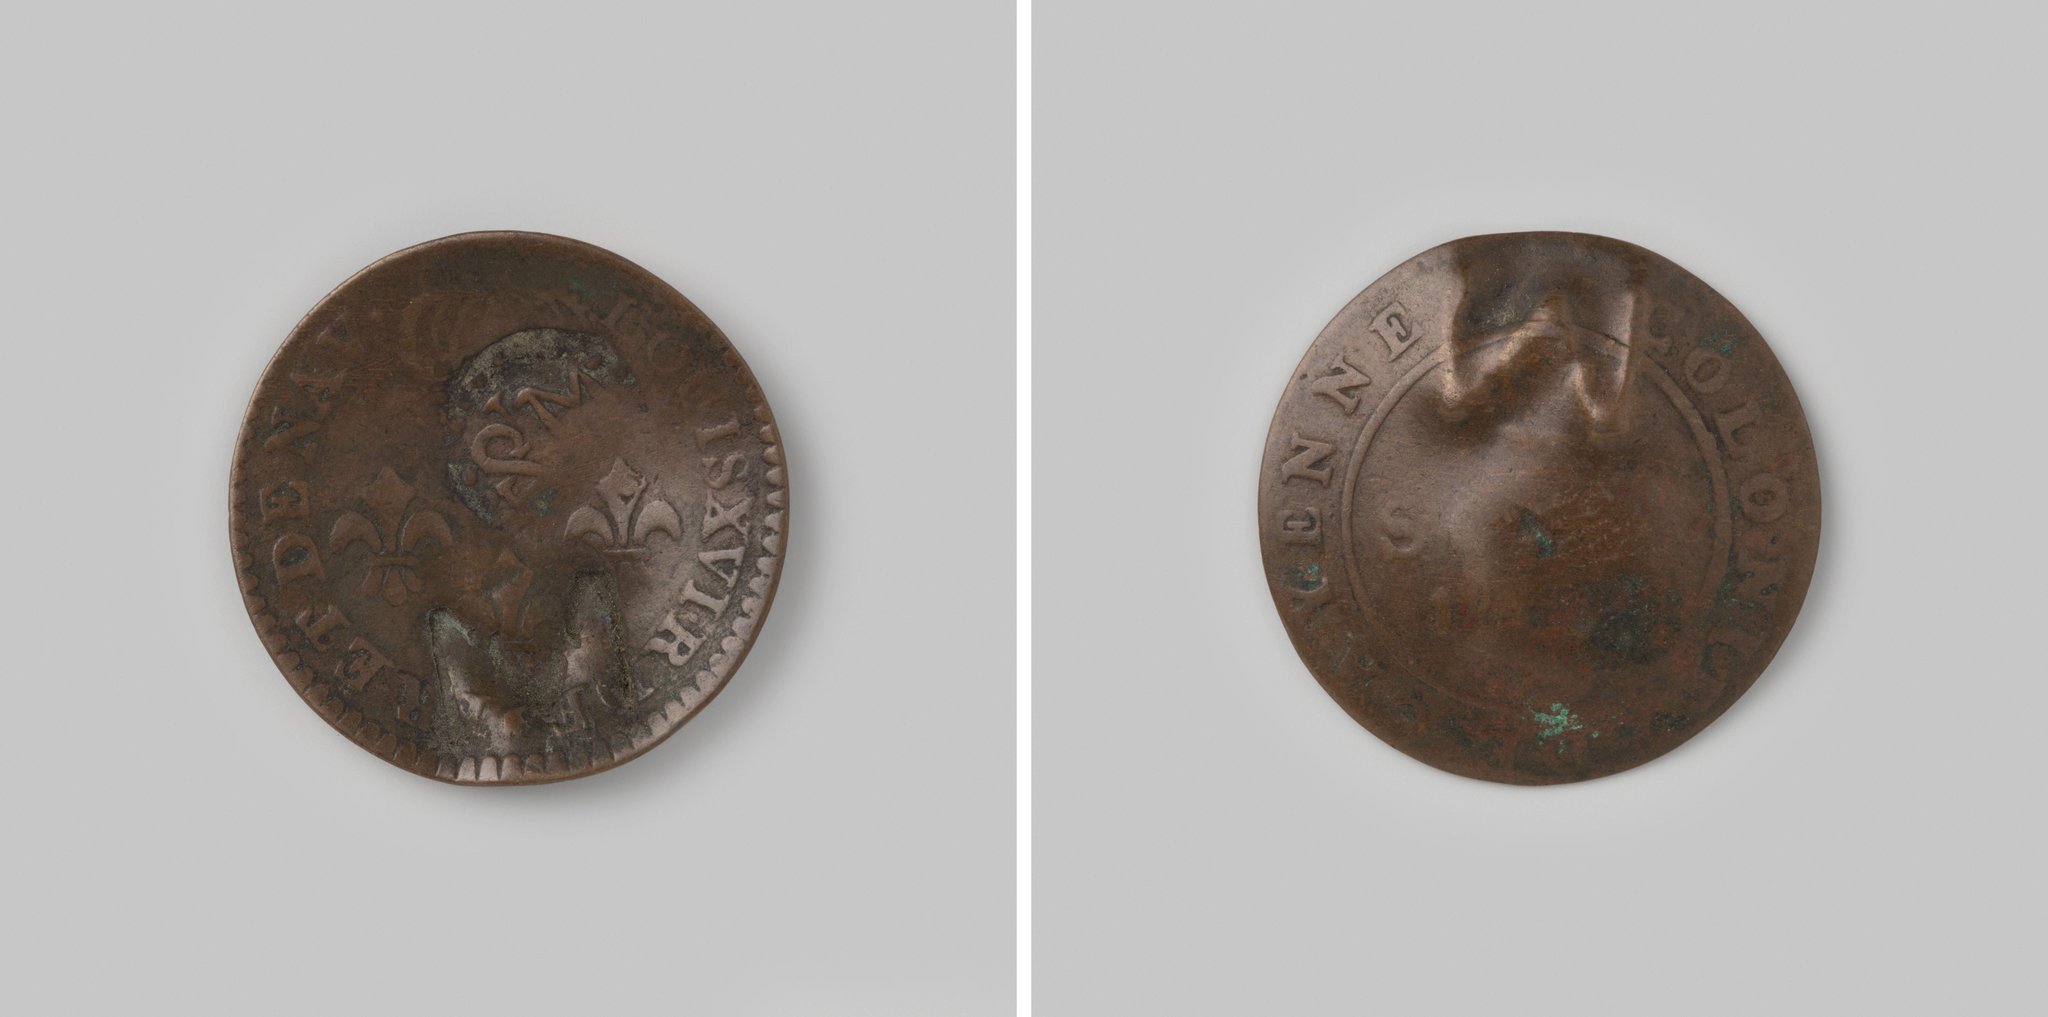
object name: coin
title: Stuiver met op Sint Maarten aangebrachte klop: St M op 2 sous uit Frans Guiana (Cayenne) van koning Lodewijk XVI, [1798]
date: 1798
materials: copper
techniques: striking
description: Koperen munt. Voorzijde: drie lelies, waarboven kroon. Keerzijde: waarde-aanduiding: 2 sous in twee regels, waaronder jaartal. Daaronder letter A [=Parijs]. Gladde rand. Met klop: St M. Ook genaamd: sou marqué, black dog.